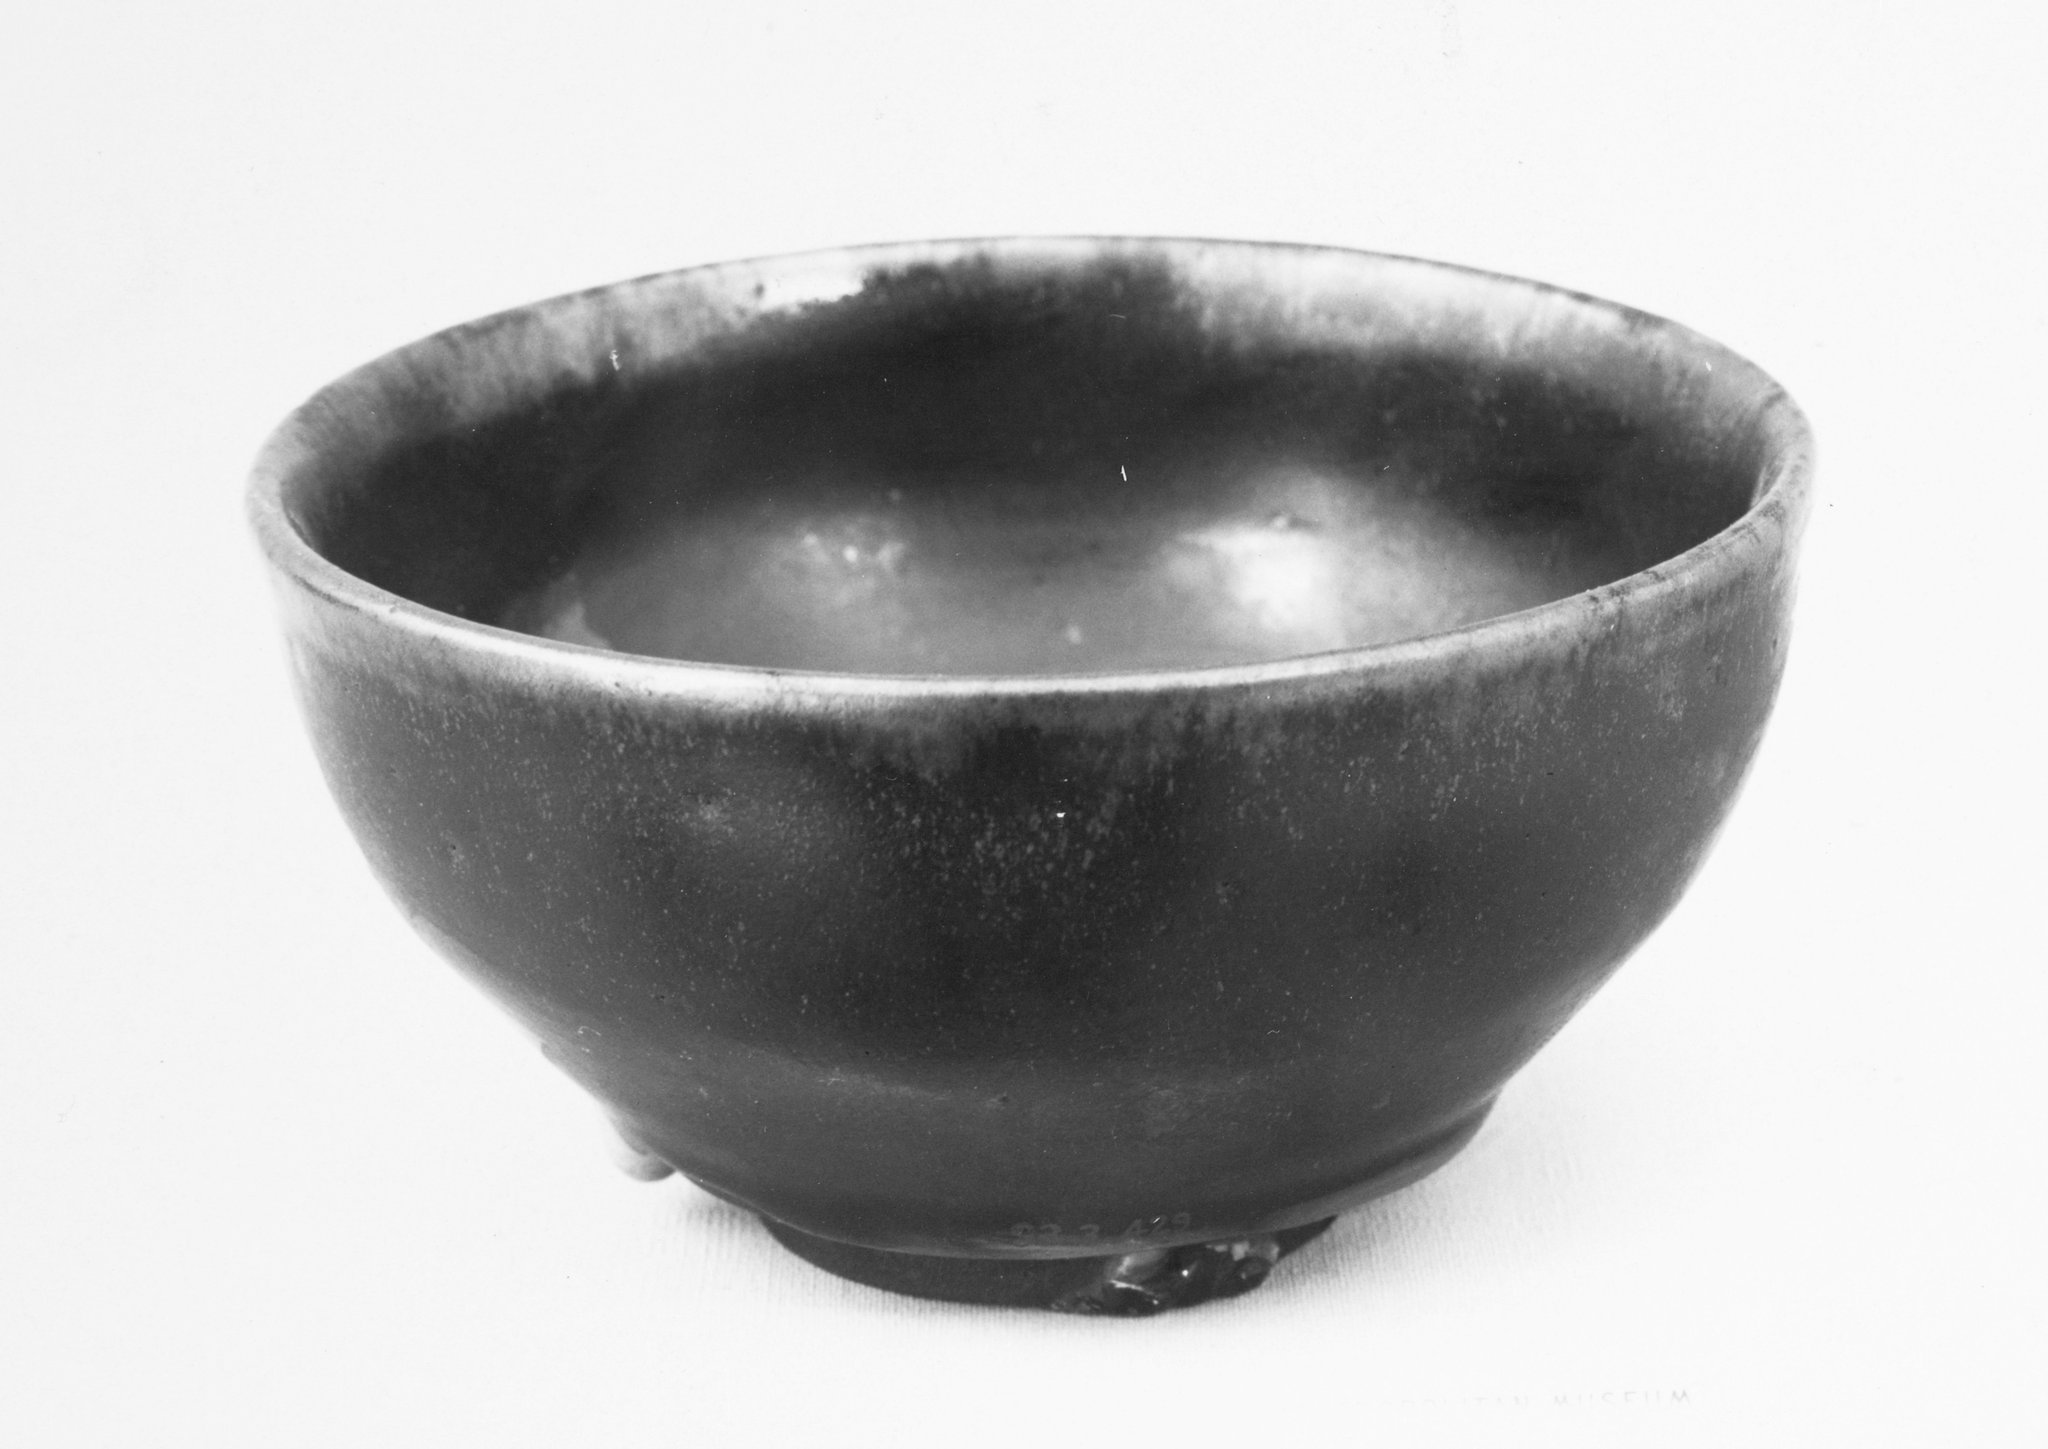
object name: cup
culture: japanese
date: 1900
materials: clay, glaze